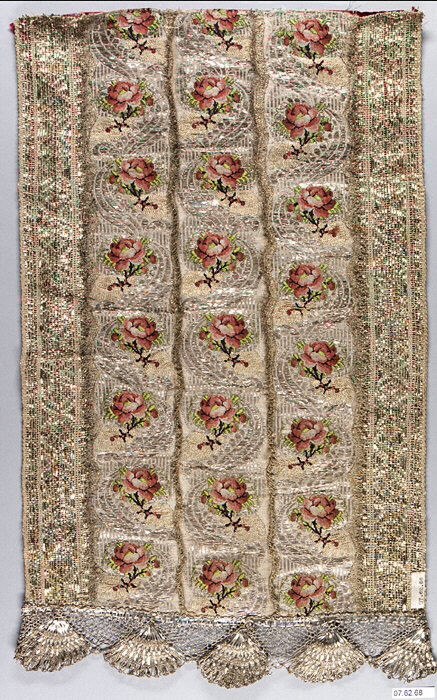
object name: ribbon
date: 1734-1766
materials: metal thread, silk